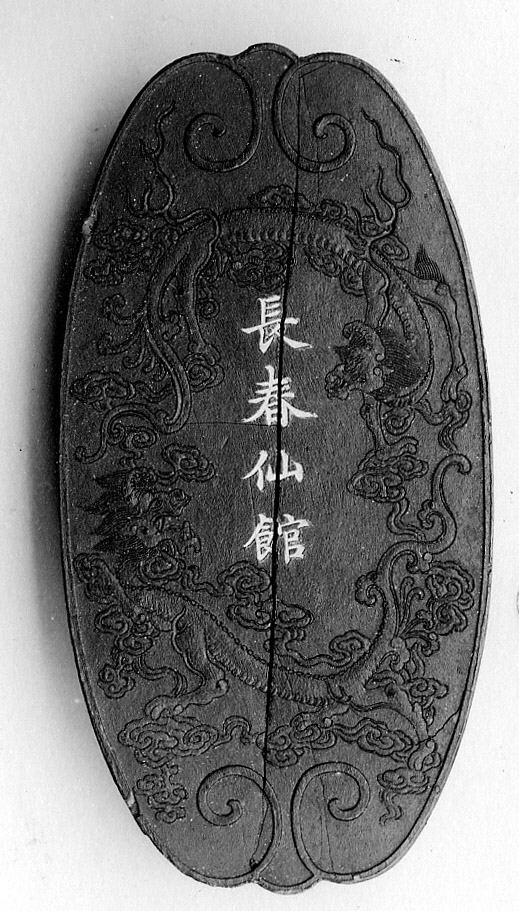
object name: ink tablet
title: The Everlasting Spring Immortal Hall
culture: chinese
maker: jian guzhai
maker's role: artist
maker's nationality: chinese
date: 1867-1933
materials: ink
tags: dragons